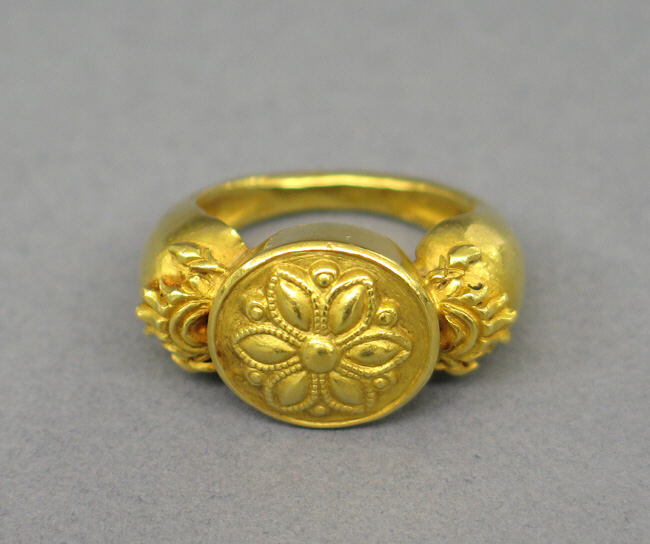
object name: ring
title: Stirruped-Shaped Ring with Circular Bezel with Lotus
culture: indonesian, javanese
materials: gold